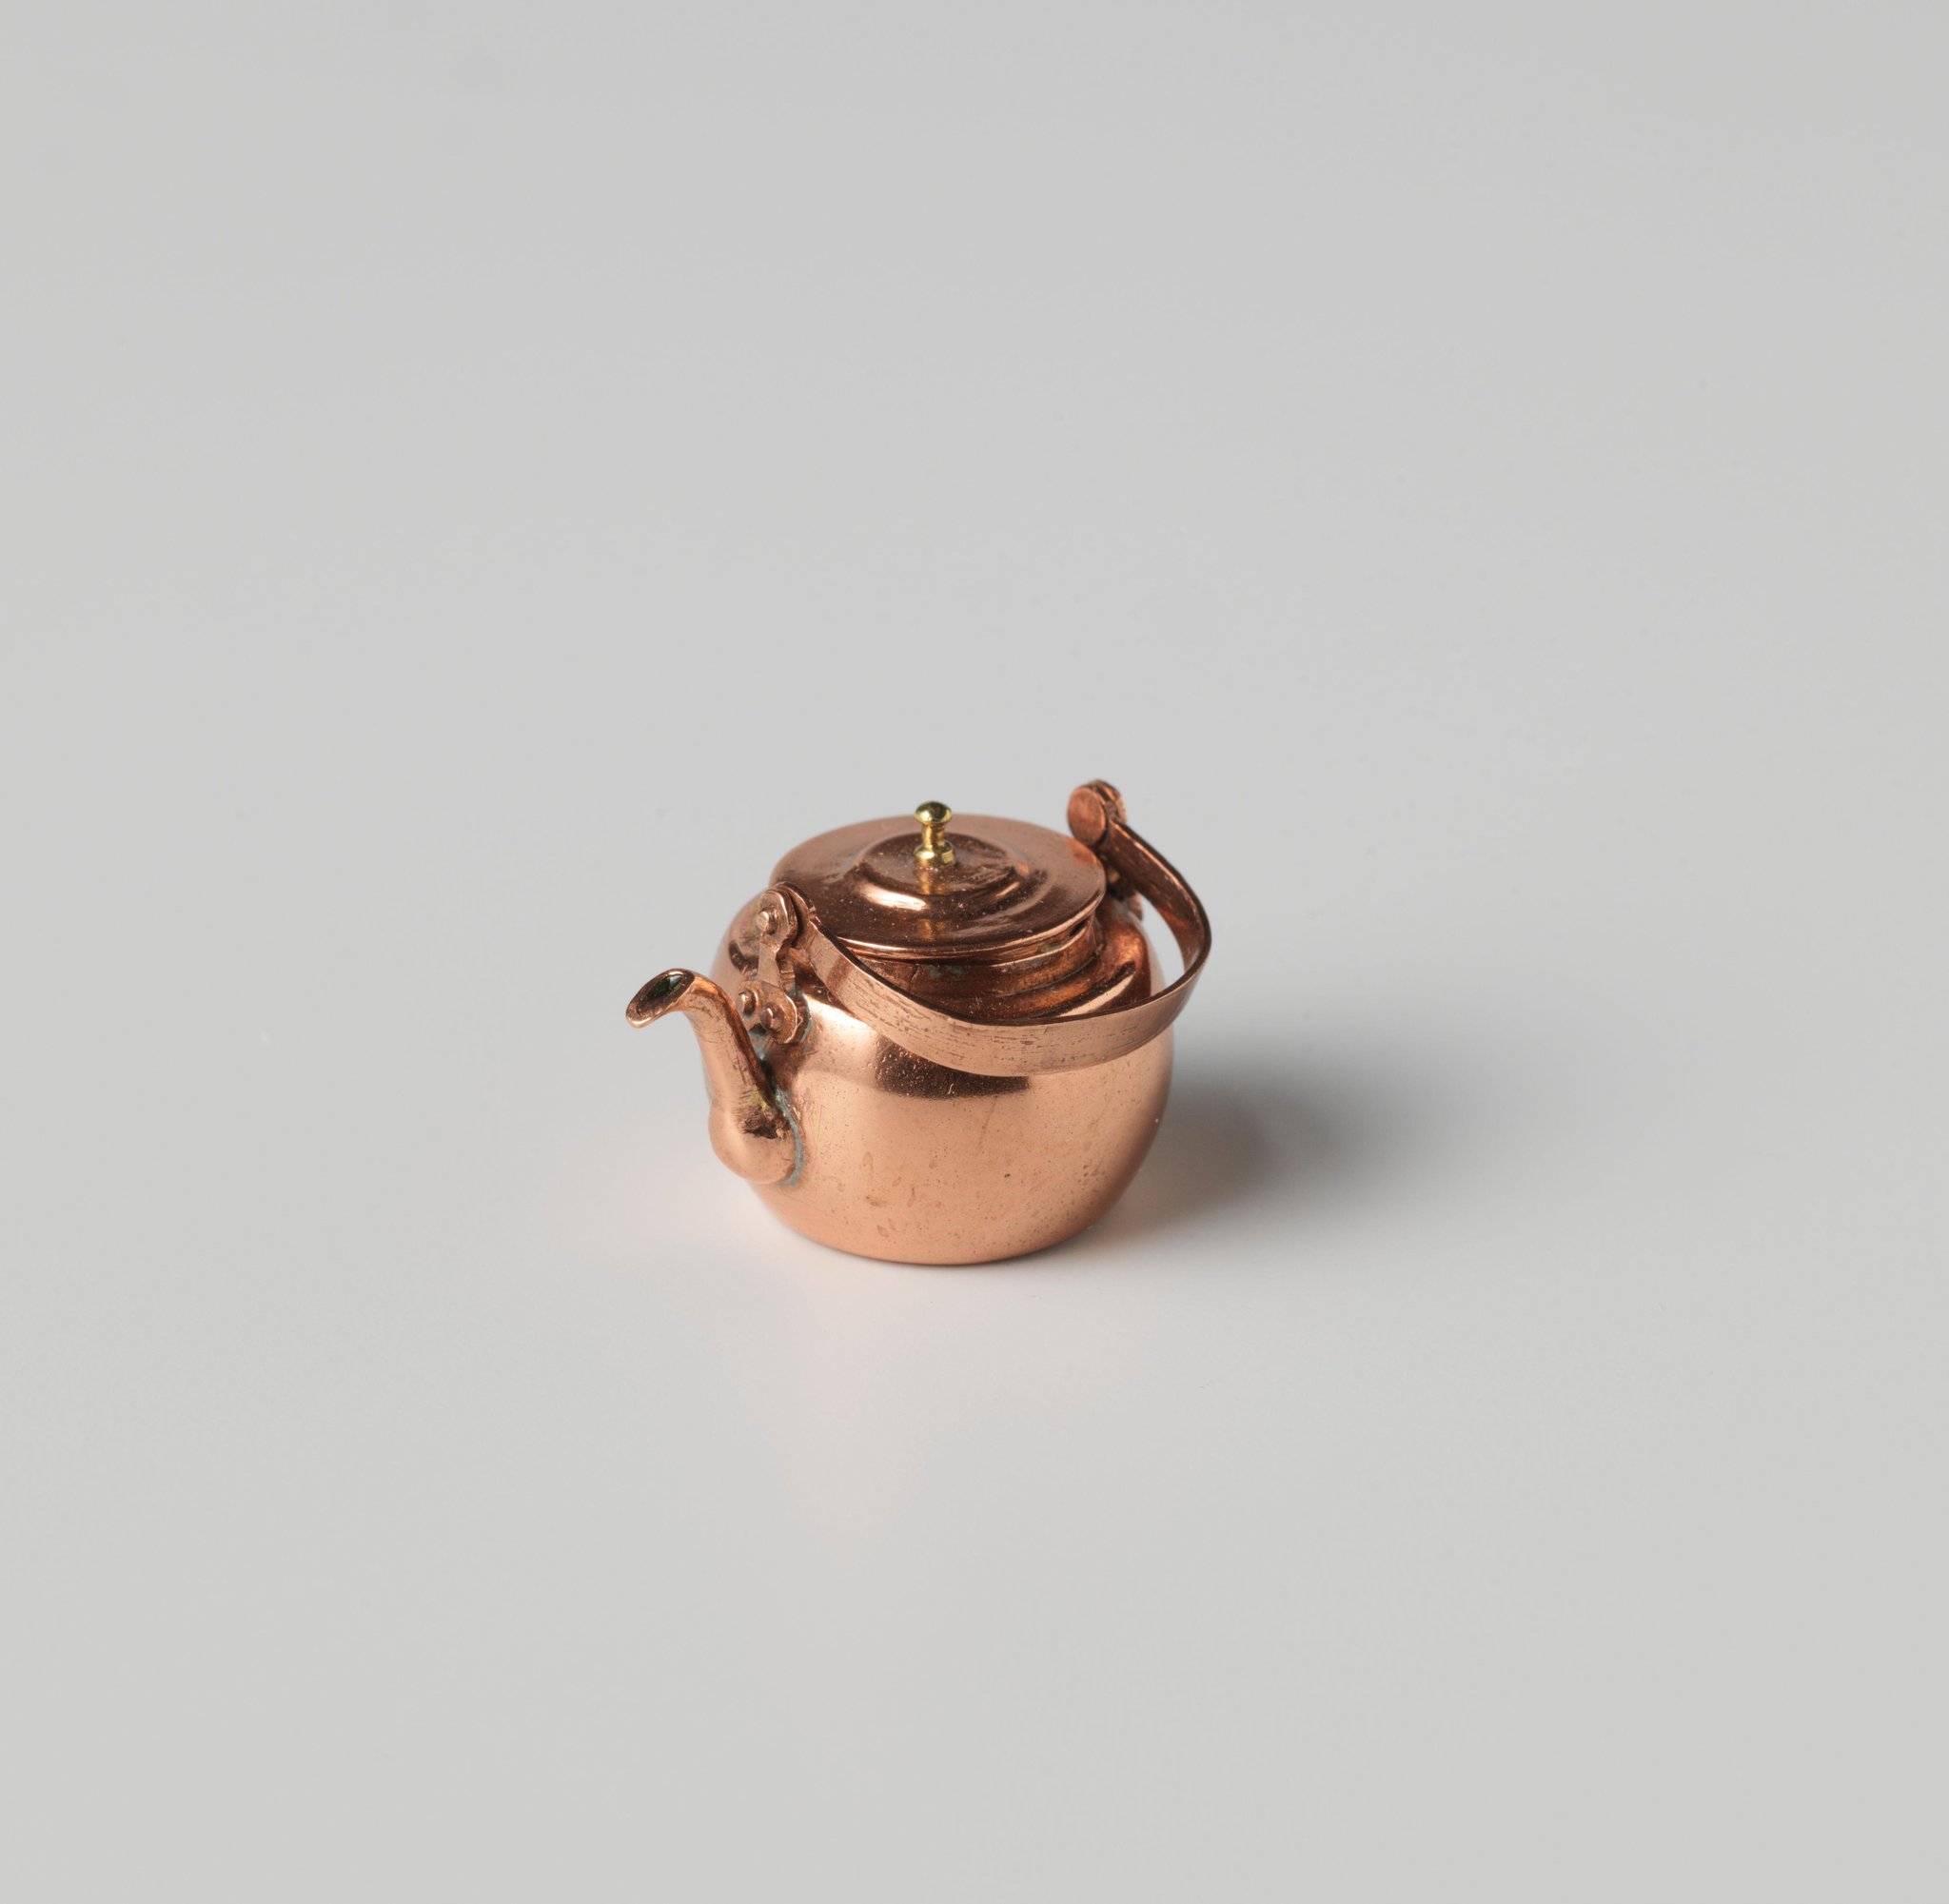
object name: teakettle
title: Waterketel met deksel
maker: Anonymous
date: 1750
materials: copper, tin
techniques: tinning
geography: amsterdam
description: Waterketel met deksel van koper, de binnenzijde vertind, het deksel met een knop.